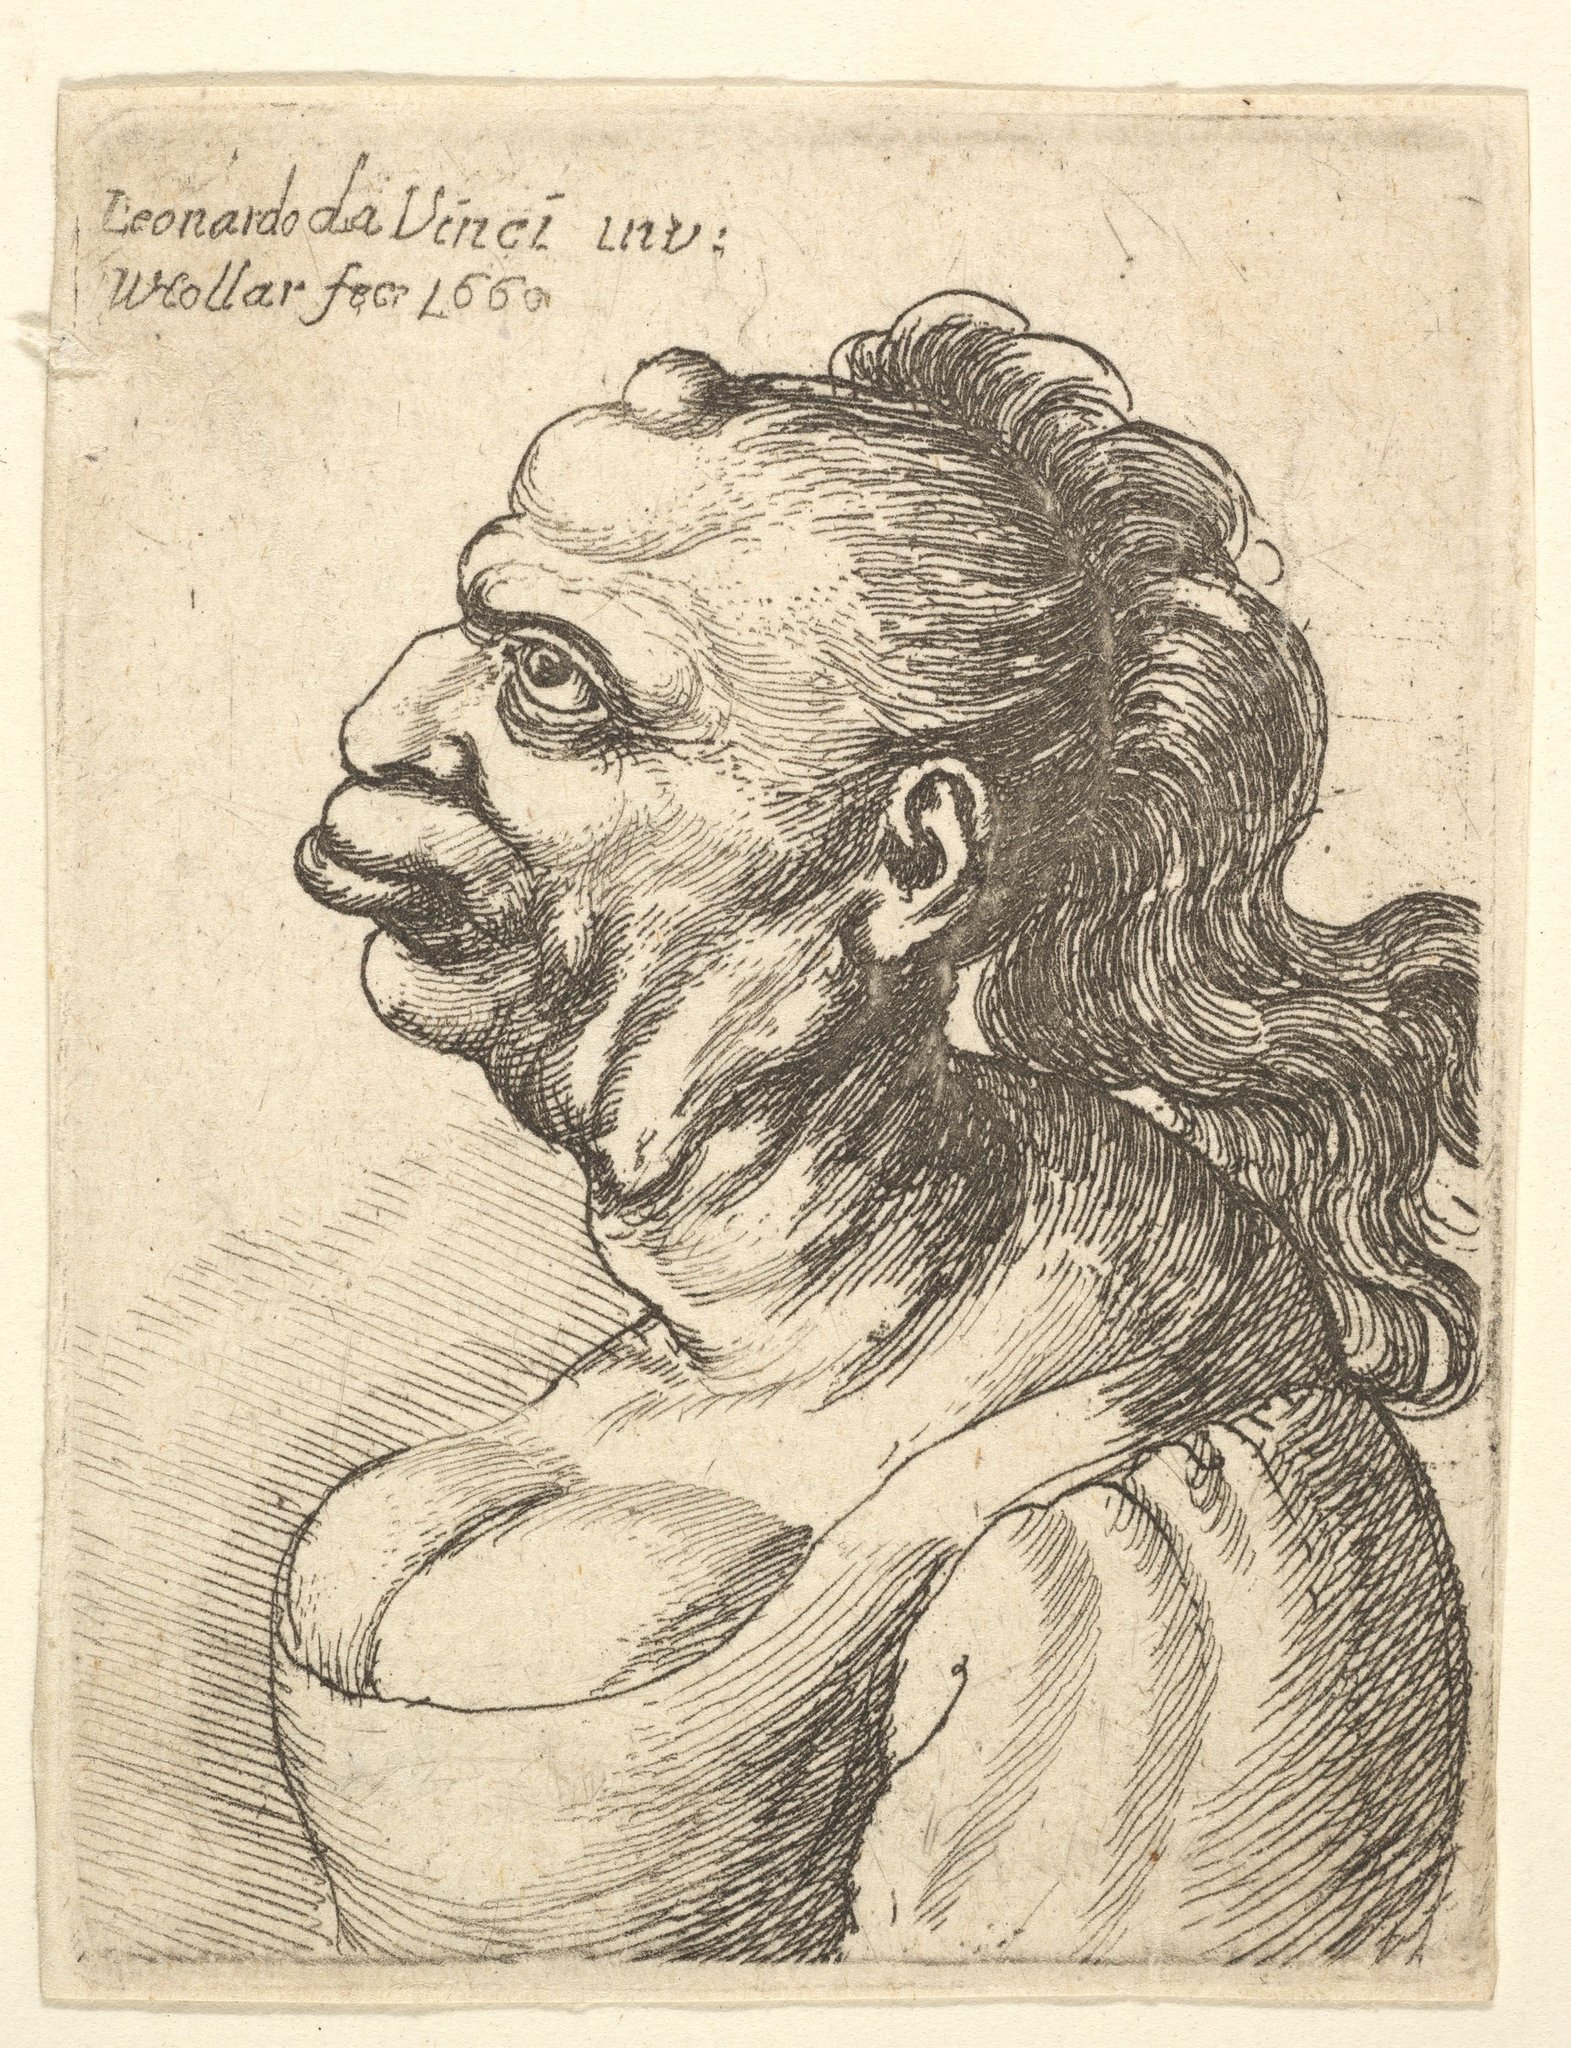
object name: print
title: Bust of a woman wearing low-cut dress, with protruding lipd, growth on her forehead, prominent breast, long flowing hair down her back, in profile to left.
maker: wenceslaus hollar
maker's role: artist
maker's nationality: bohemian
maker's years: 1607-1677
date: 1660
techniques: etching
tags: women